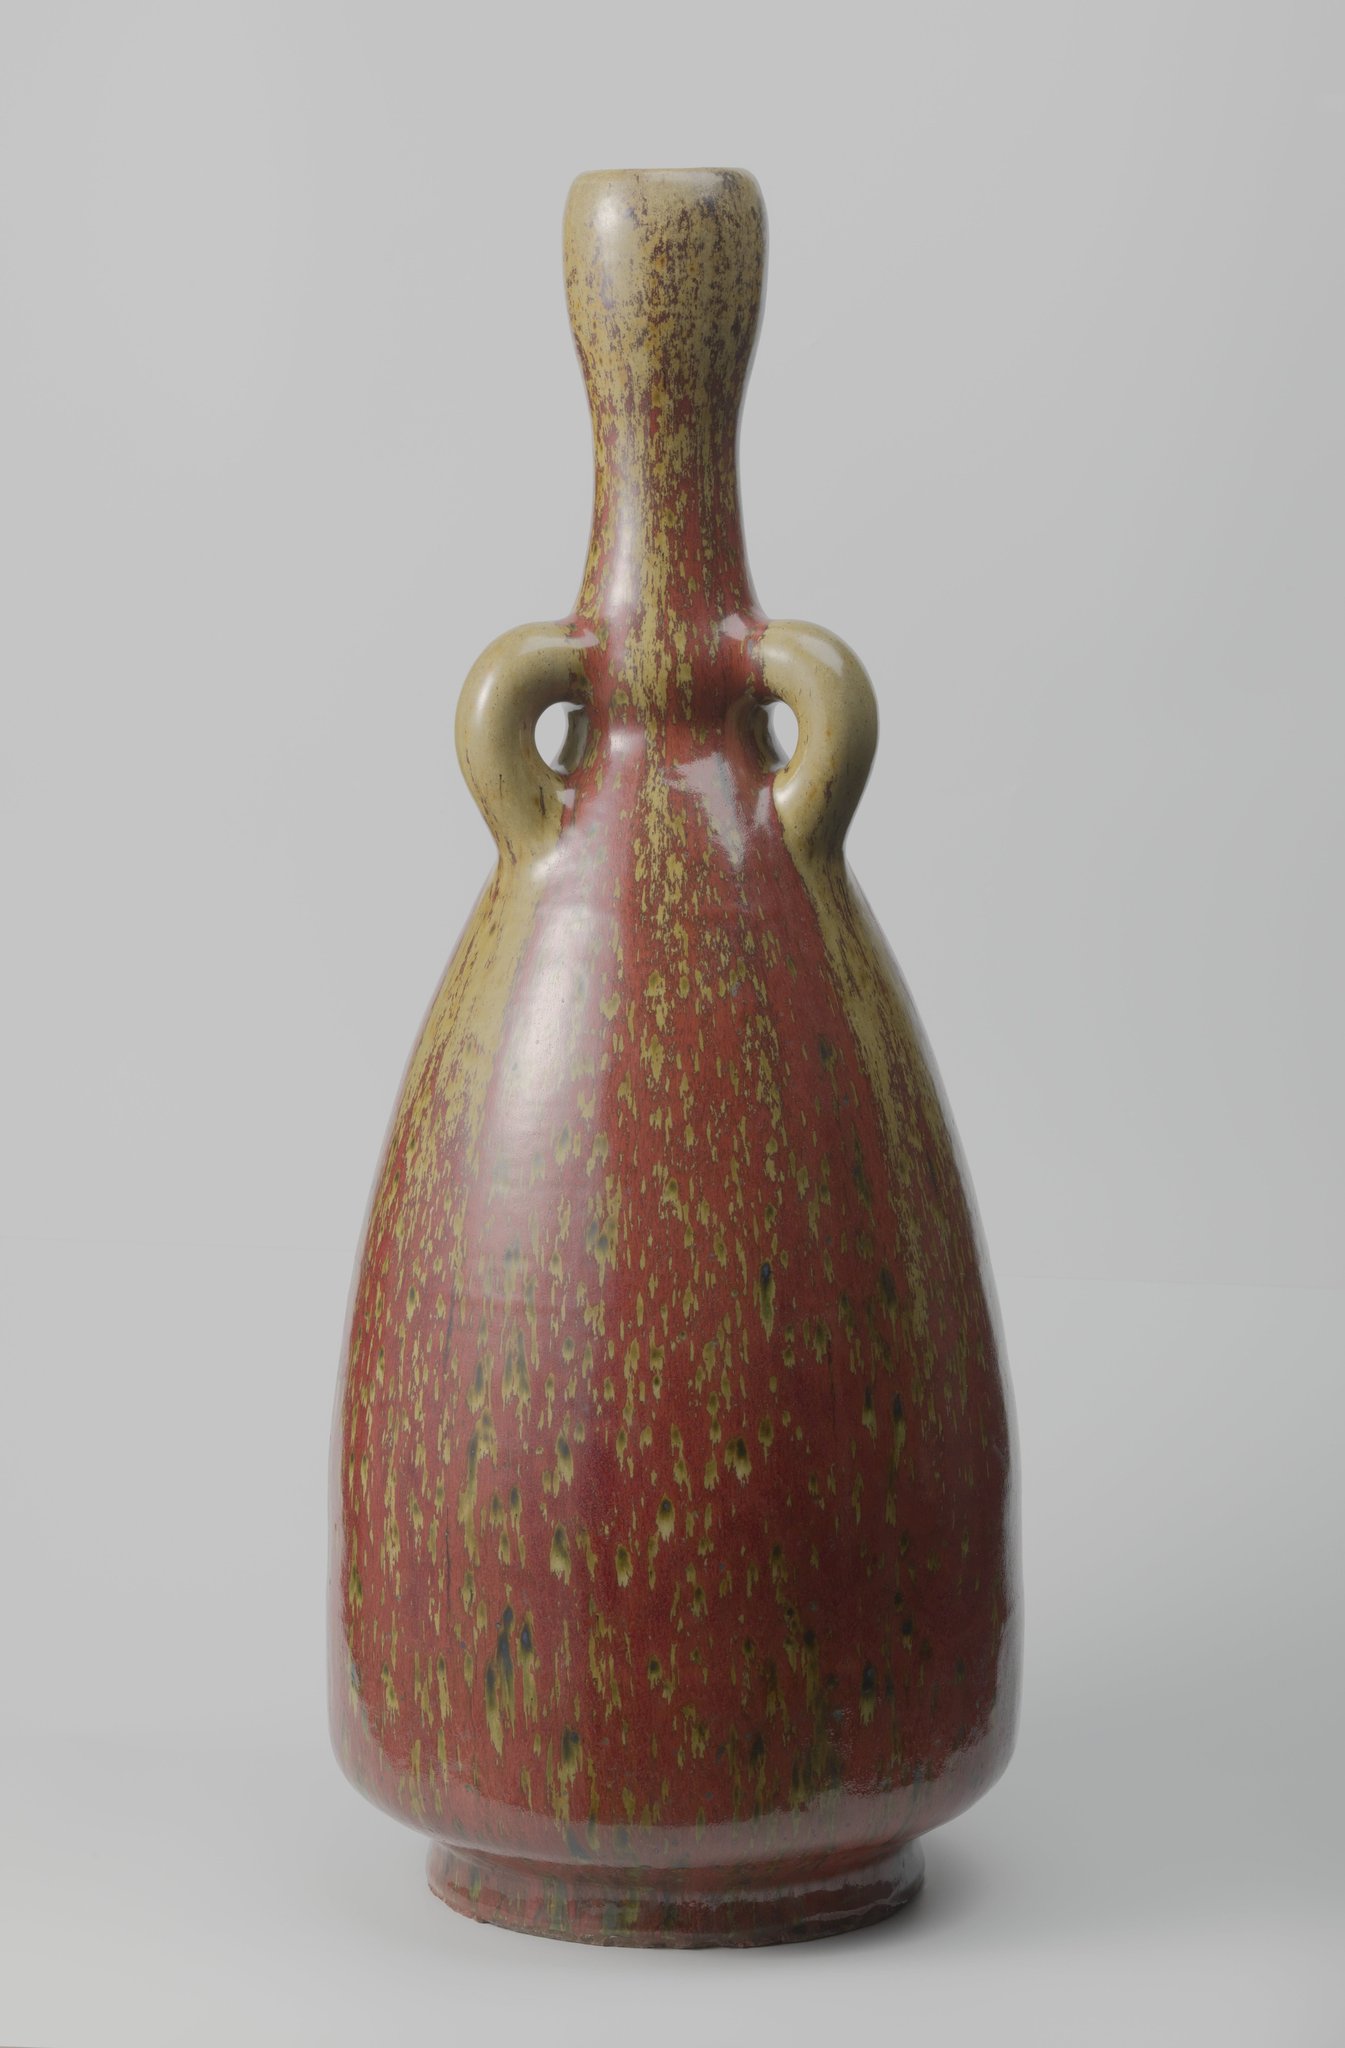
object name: vase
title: Vase with Three Handles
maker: pierre adrien dalpayrat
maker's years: 1844-1910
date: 1895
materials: glaze, stoneware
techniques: firing, vitrification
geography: bourg-la-reine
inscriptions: mark: ‘een ingestempelde vlammende kogel’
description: Vaas van steengoed met drie oren op een hoge inspringende voet en een slanke hals. Bedekt met een rode, geel gevlekte, glazuur. De oren zijn geheel geel. In de bodem zit een rond gat. De vaas in gemerkt met een ingestempelde vlammende kogel aan de buitenzijde van de voetrand.